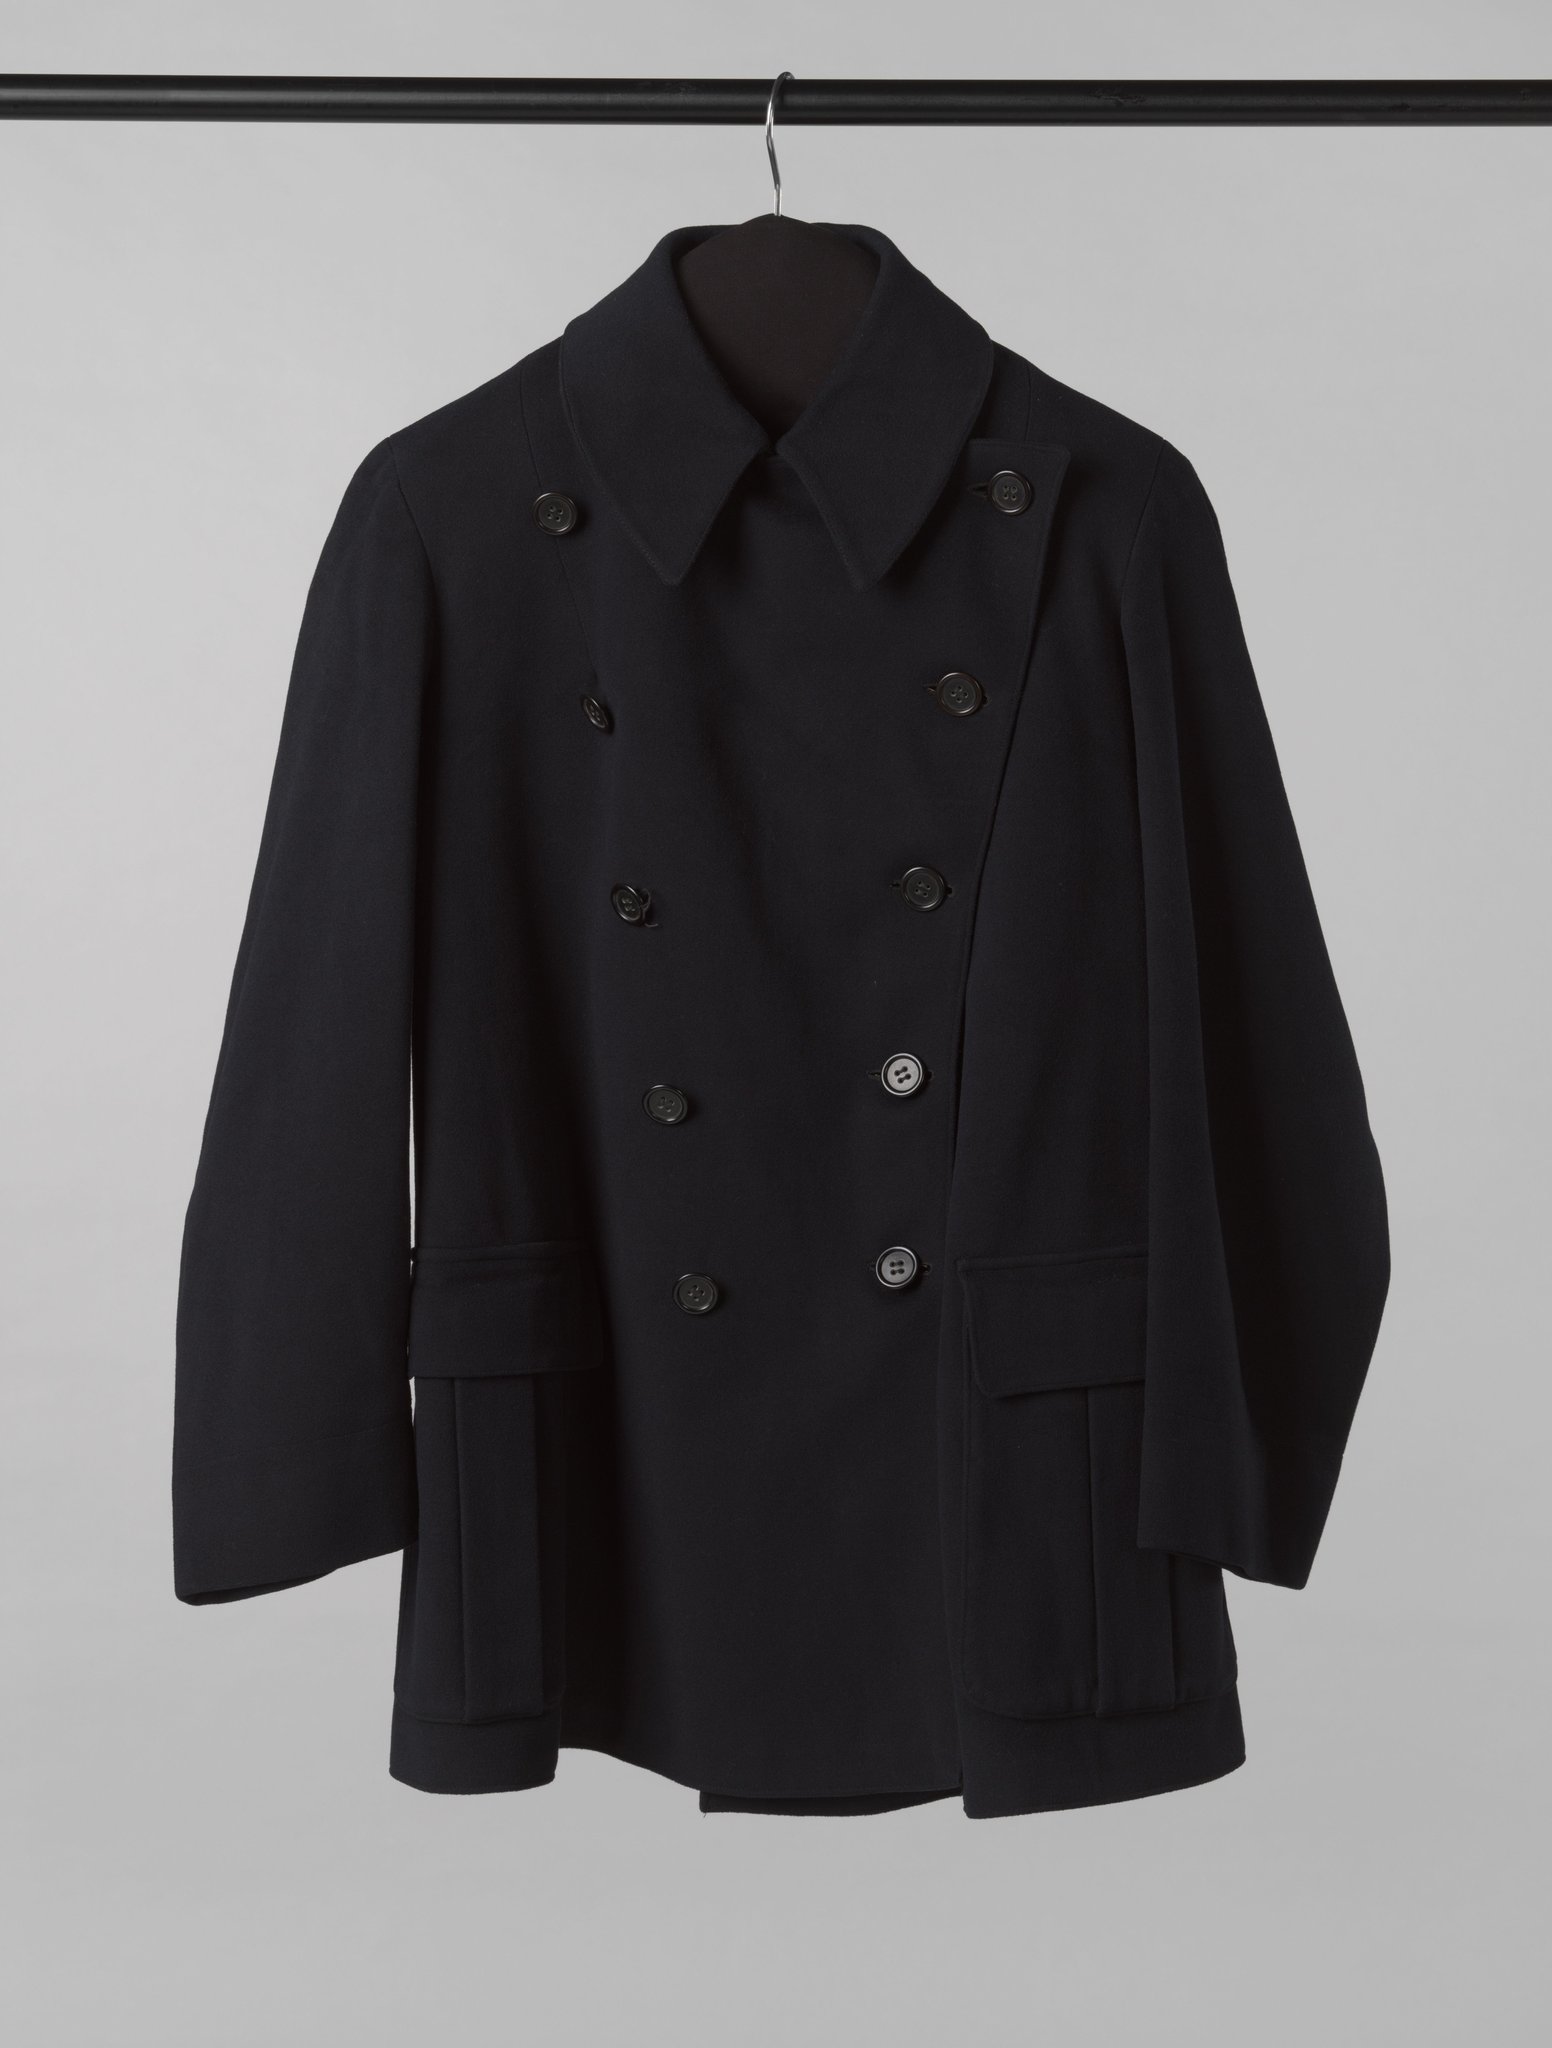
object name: sport clothing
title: Korte jas met ruime overslag, sluiting met dubbele rij zwarte benen knopen en twee opgenaaide zakken met stolpplooi en klep van zwart laken, gevoerd met zwart satinet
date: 1910-1925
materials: bone, textile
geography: amsterdam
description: Jas van zwart laken, onderdeel van chauffeurspak. Kort jekkermodel. Twee rechte rugpanden en gerend gesneden zijpanden. Ruime overslag, sluiting met dubbele rij benen knopen. Twee rechte opgenaaide zakken, elk met een stolpplooi en klep. Rechte mouwen met boven- en ondernaad. Zwart satinetvoering. Adres: "warrented english make p & sl./specially made for 'nieuw engeland'/Amsterdam-Koningsplein/buying-office/London E.C. 9776-Amsterdam, 'nieuw engeland".